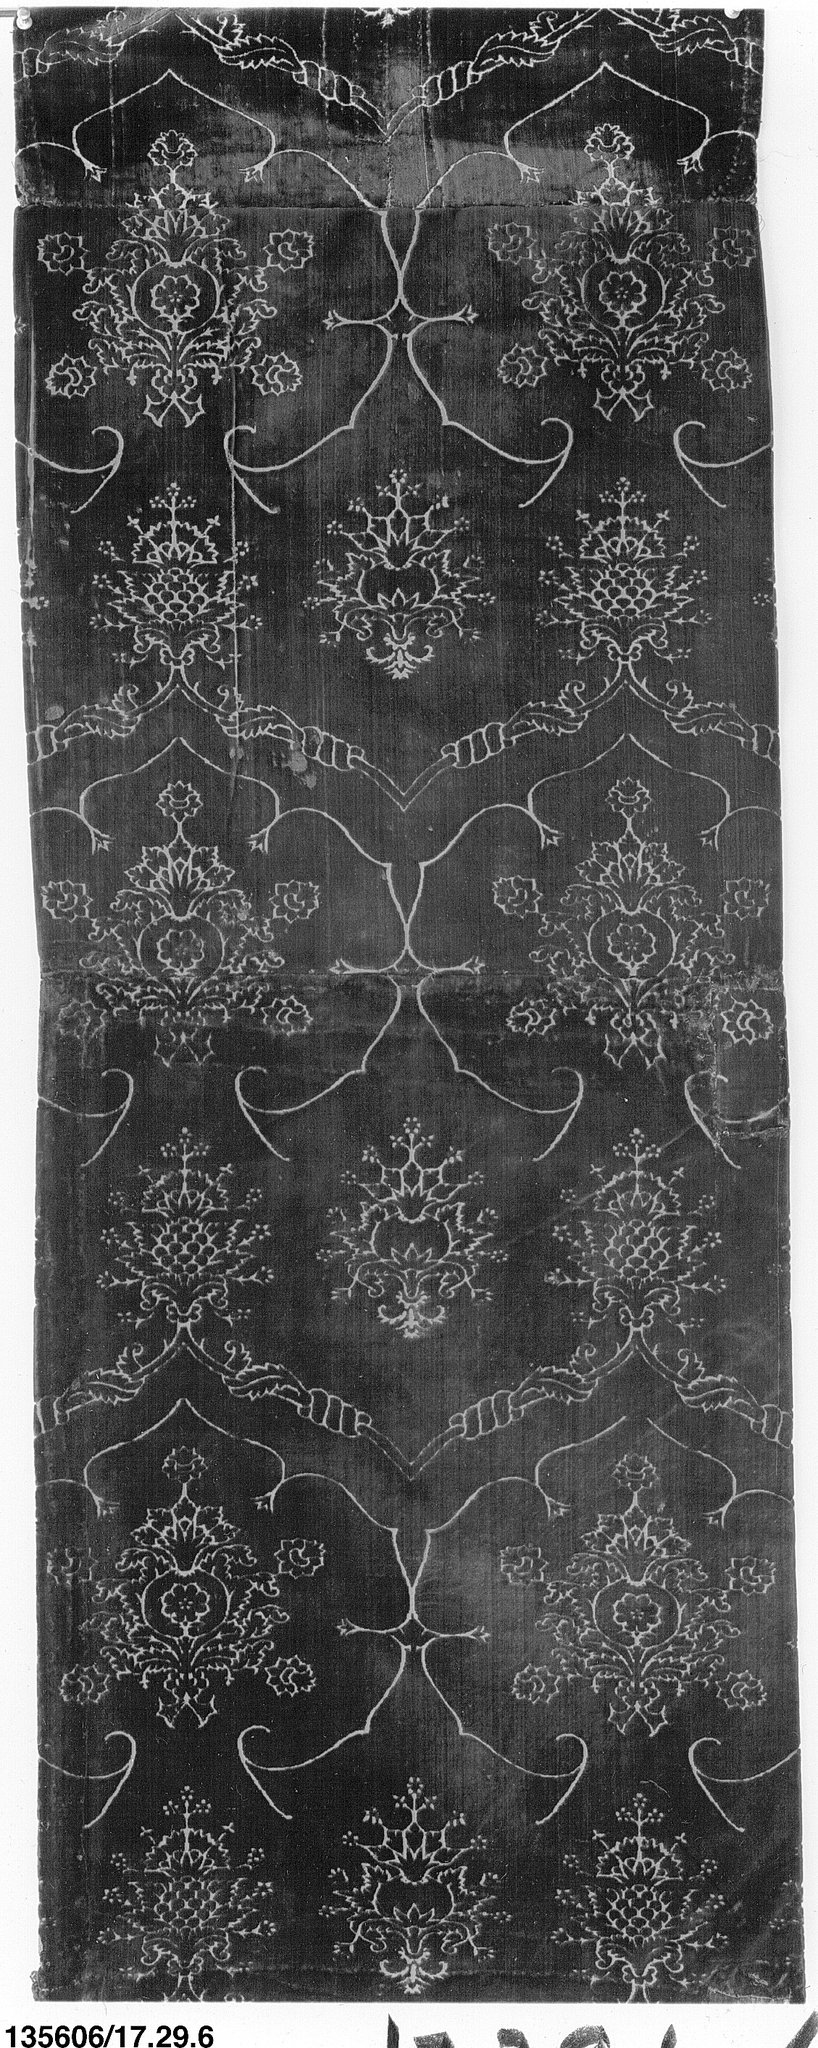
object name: panel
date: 1401-1500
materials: silk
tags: flowers,leaves